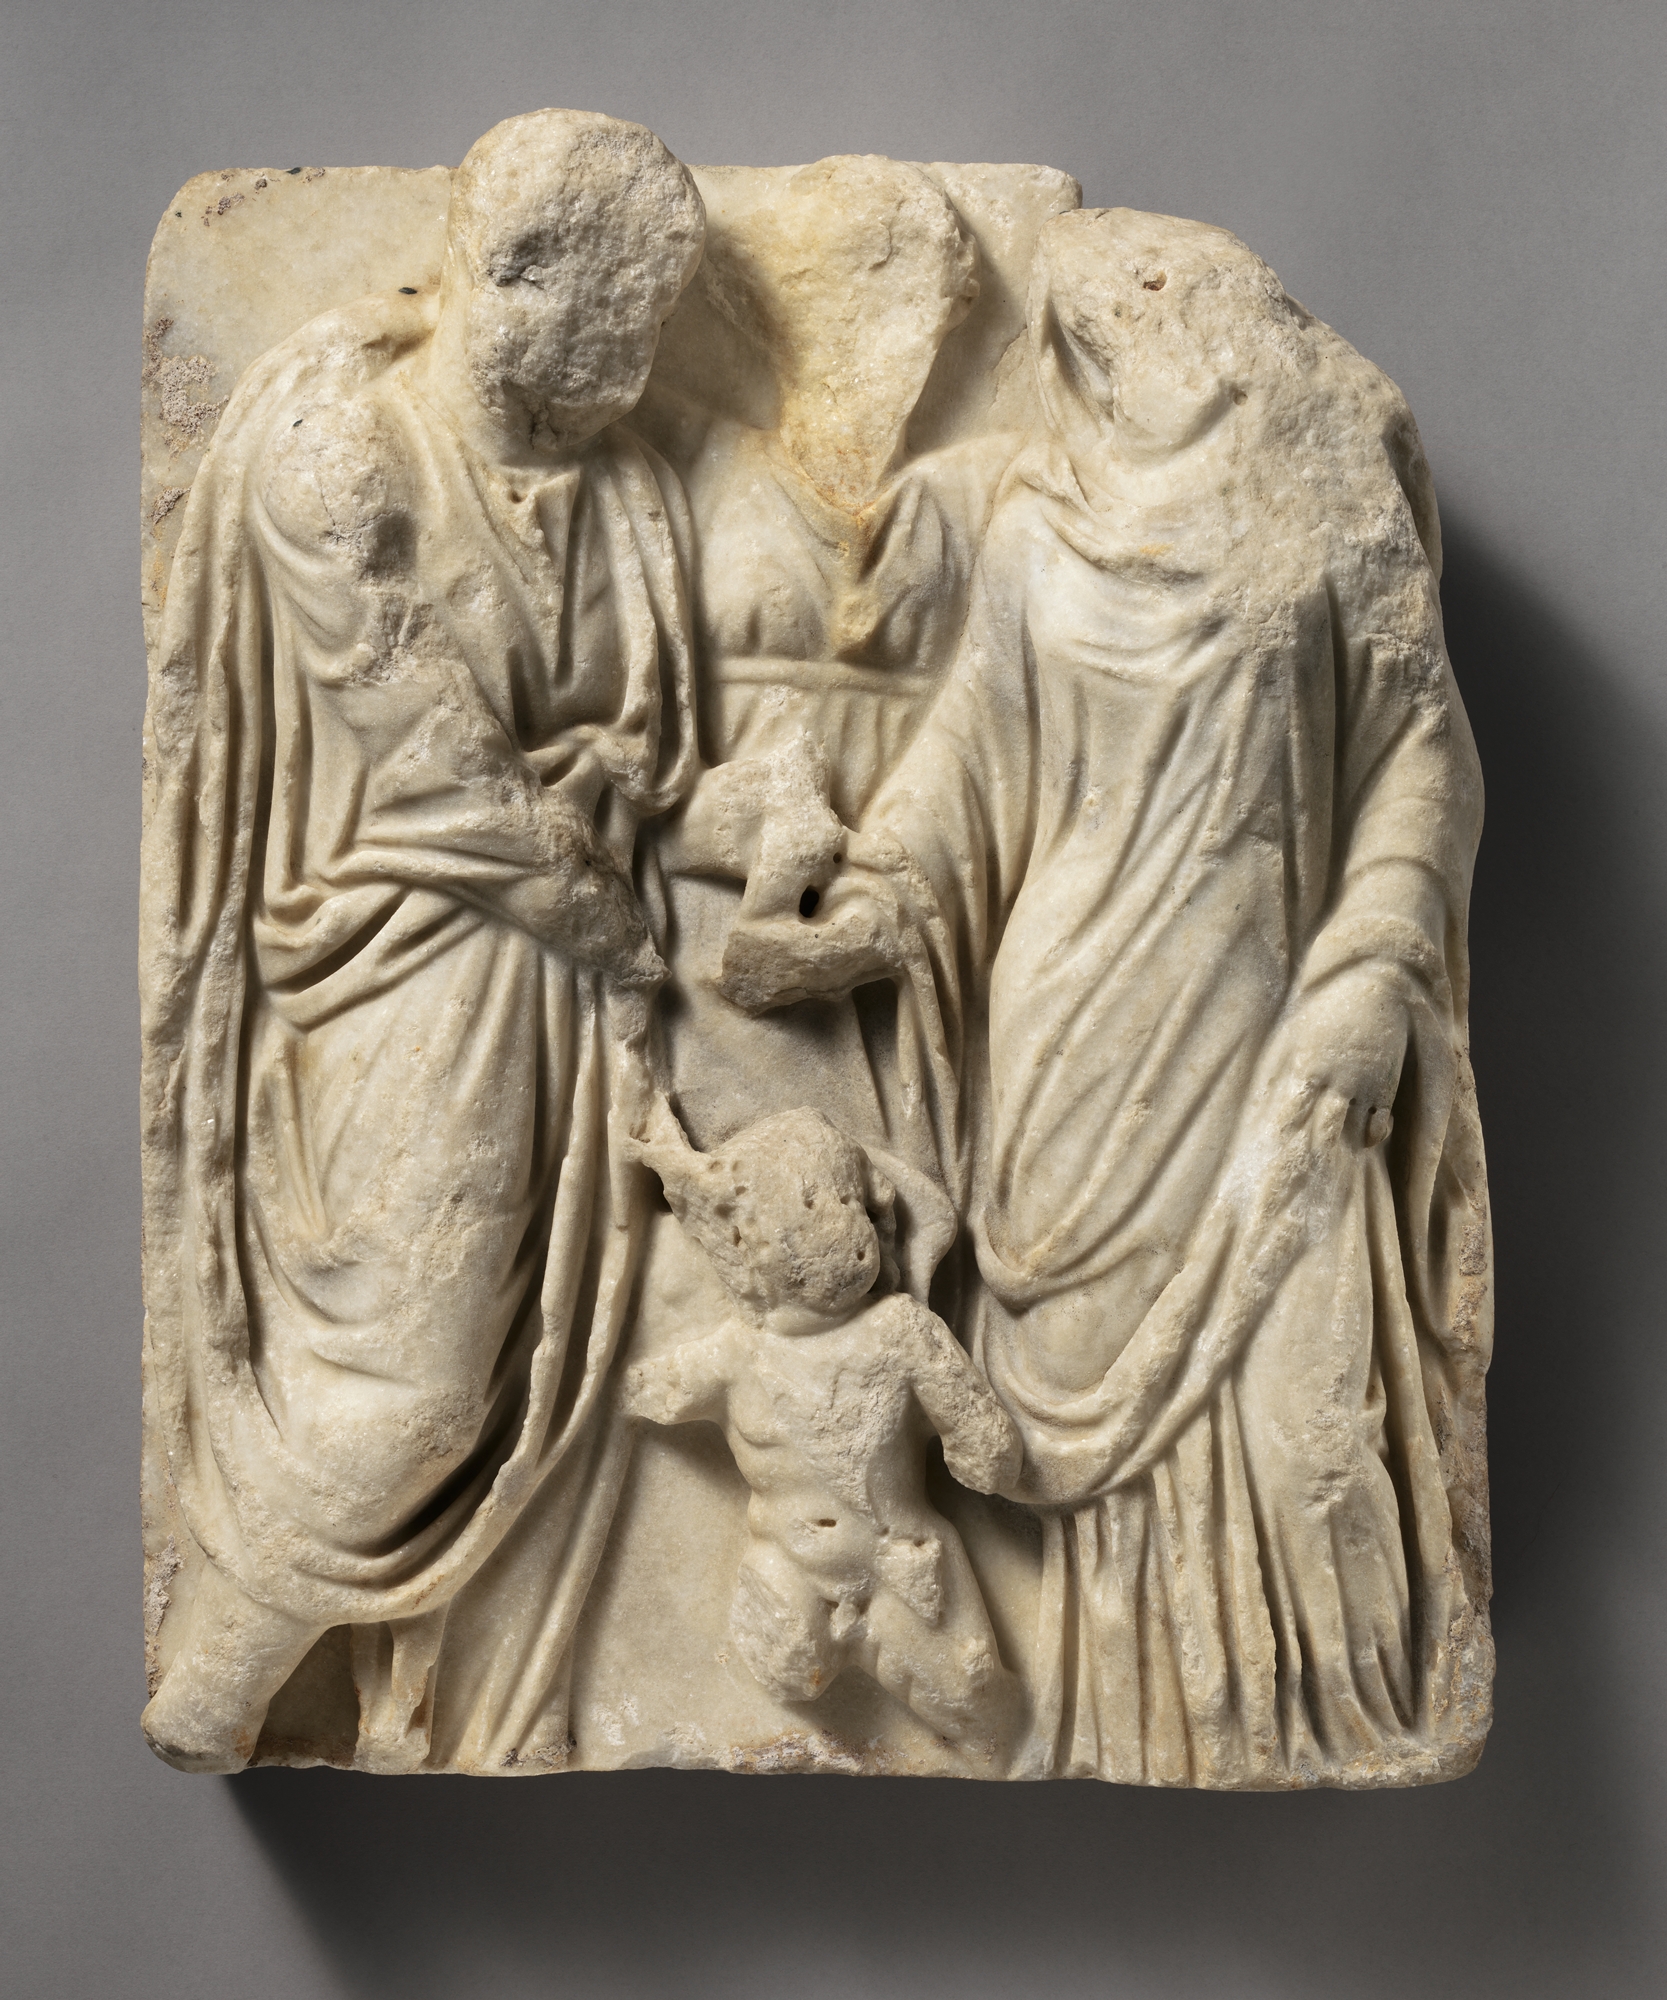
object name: sarcophagus fragment, marriage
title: Marble sarcophagus fragment: marriage scene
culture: roman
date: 201-233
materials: marble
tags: couples,men,women,eros